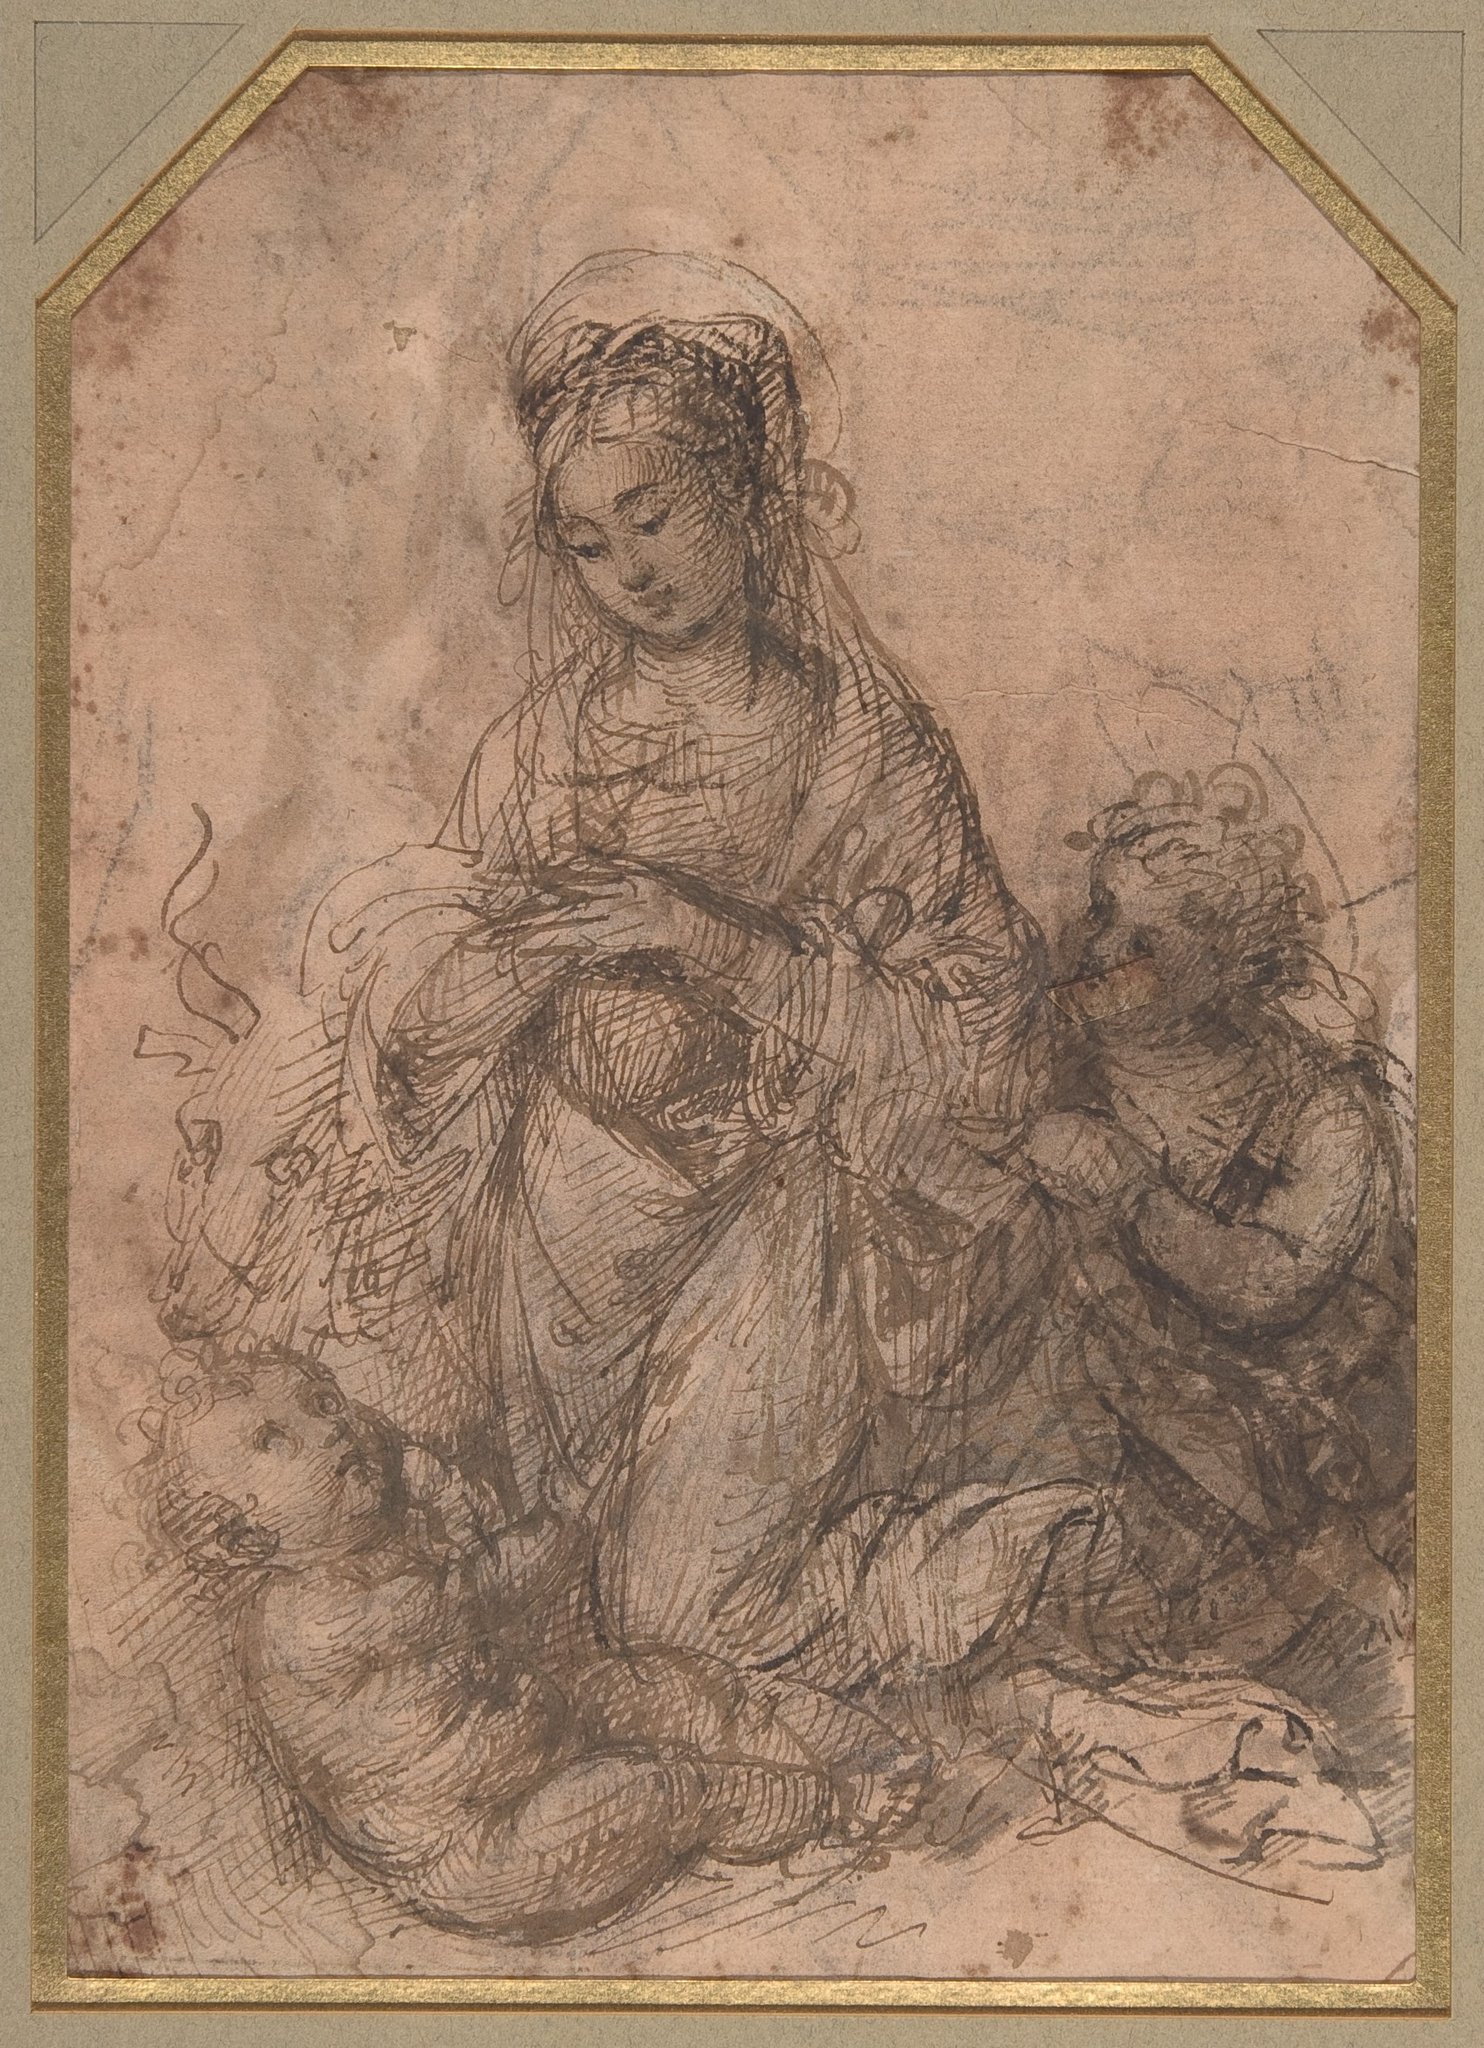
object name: drawing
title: Virgin Adoring the Christ Child with Saint John the Baptist (recto); The Holy Family with Saint John the Baptist (verso)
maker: agnolo del mazziere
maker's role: artist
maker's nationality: italian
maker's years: 1465-1513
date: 1500-1515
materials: chalk, ink, paper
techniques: brush, pen, wash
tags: holy family,madonna and child,saint john the baptist